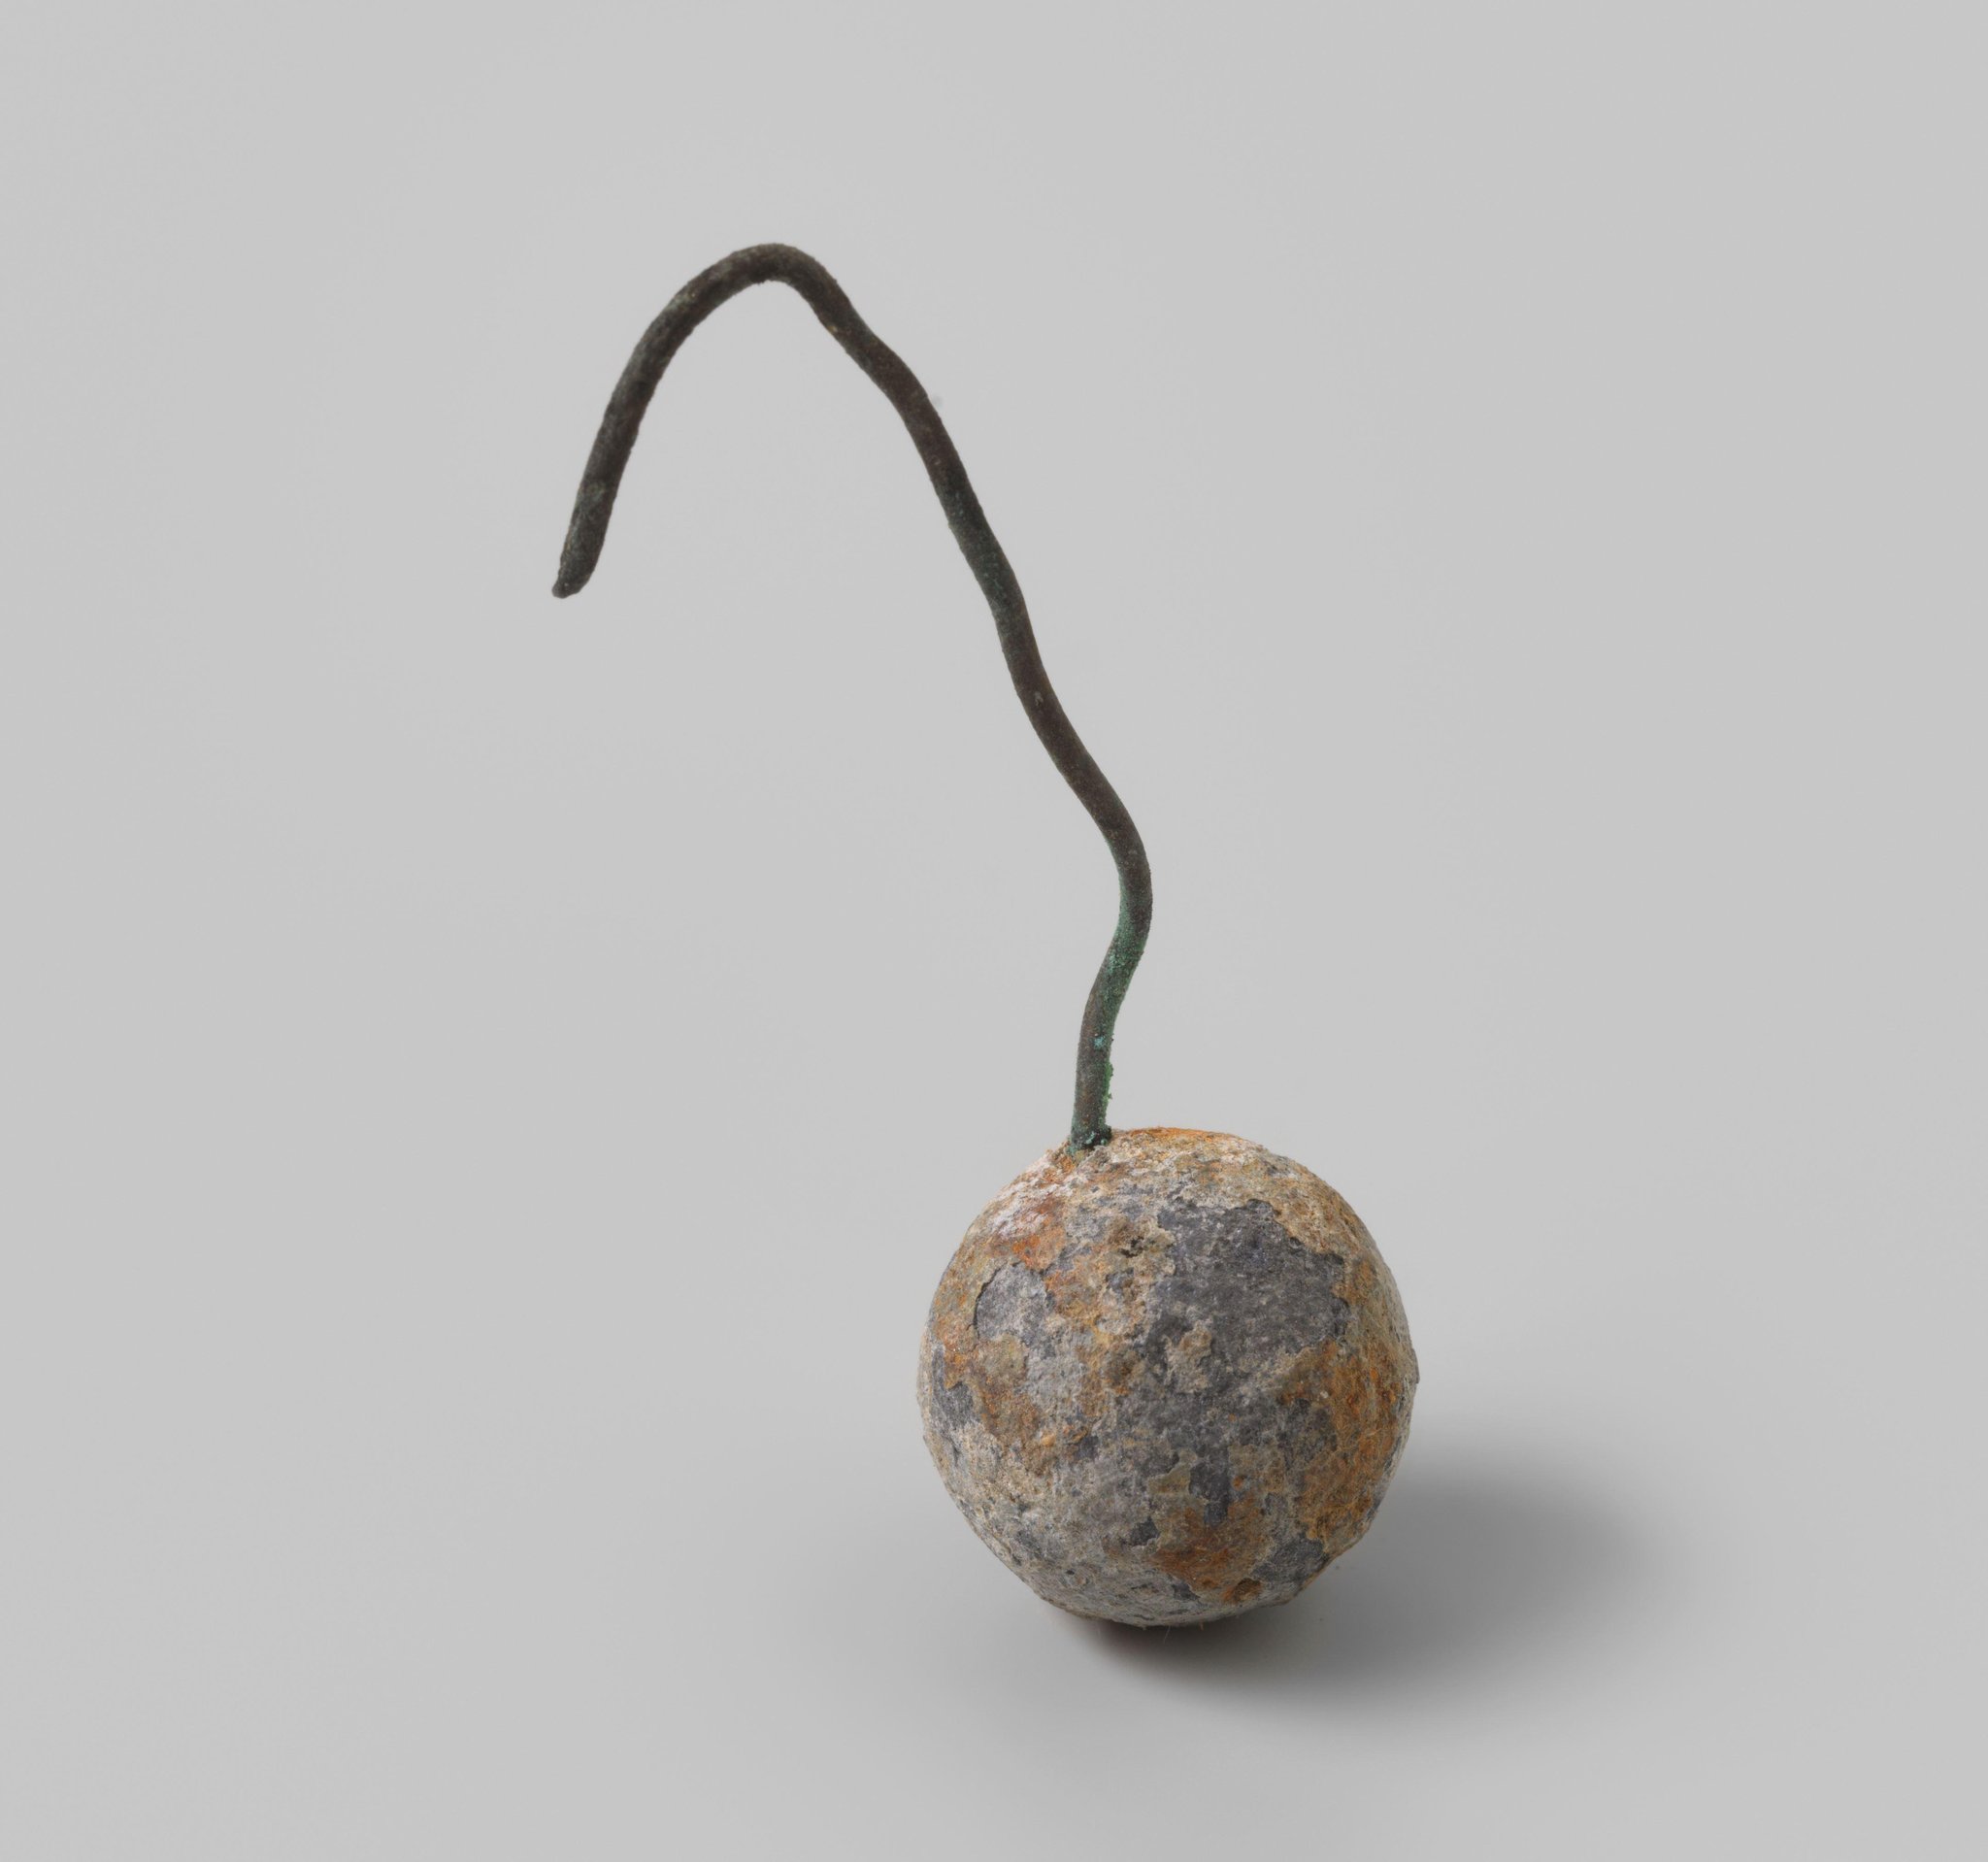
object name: chain shot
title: Kettingkogel uit het wrak van de Oost-Indiëvaarder Hollandia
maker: Anonymous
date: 1700-1743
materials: lead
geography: netherlands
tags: verenigde oostindische compagnie, hollandia (schip), annet